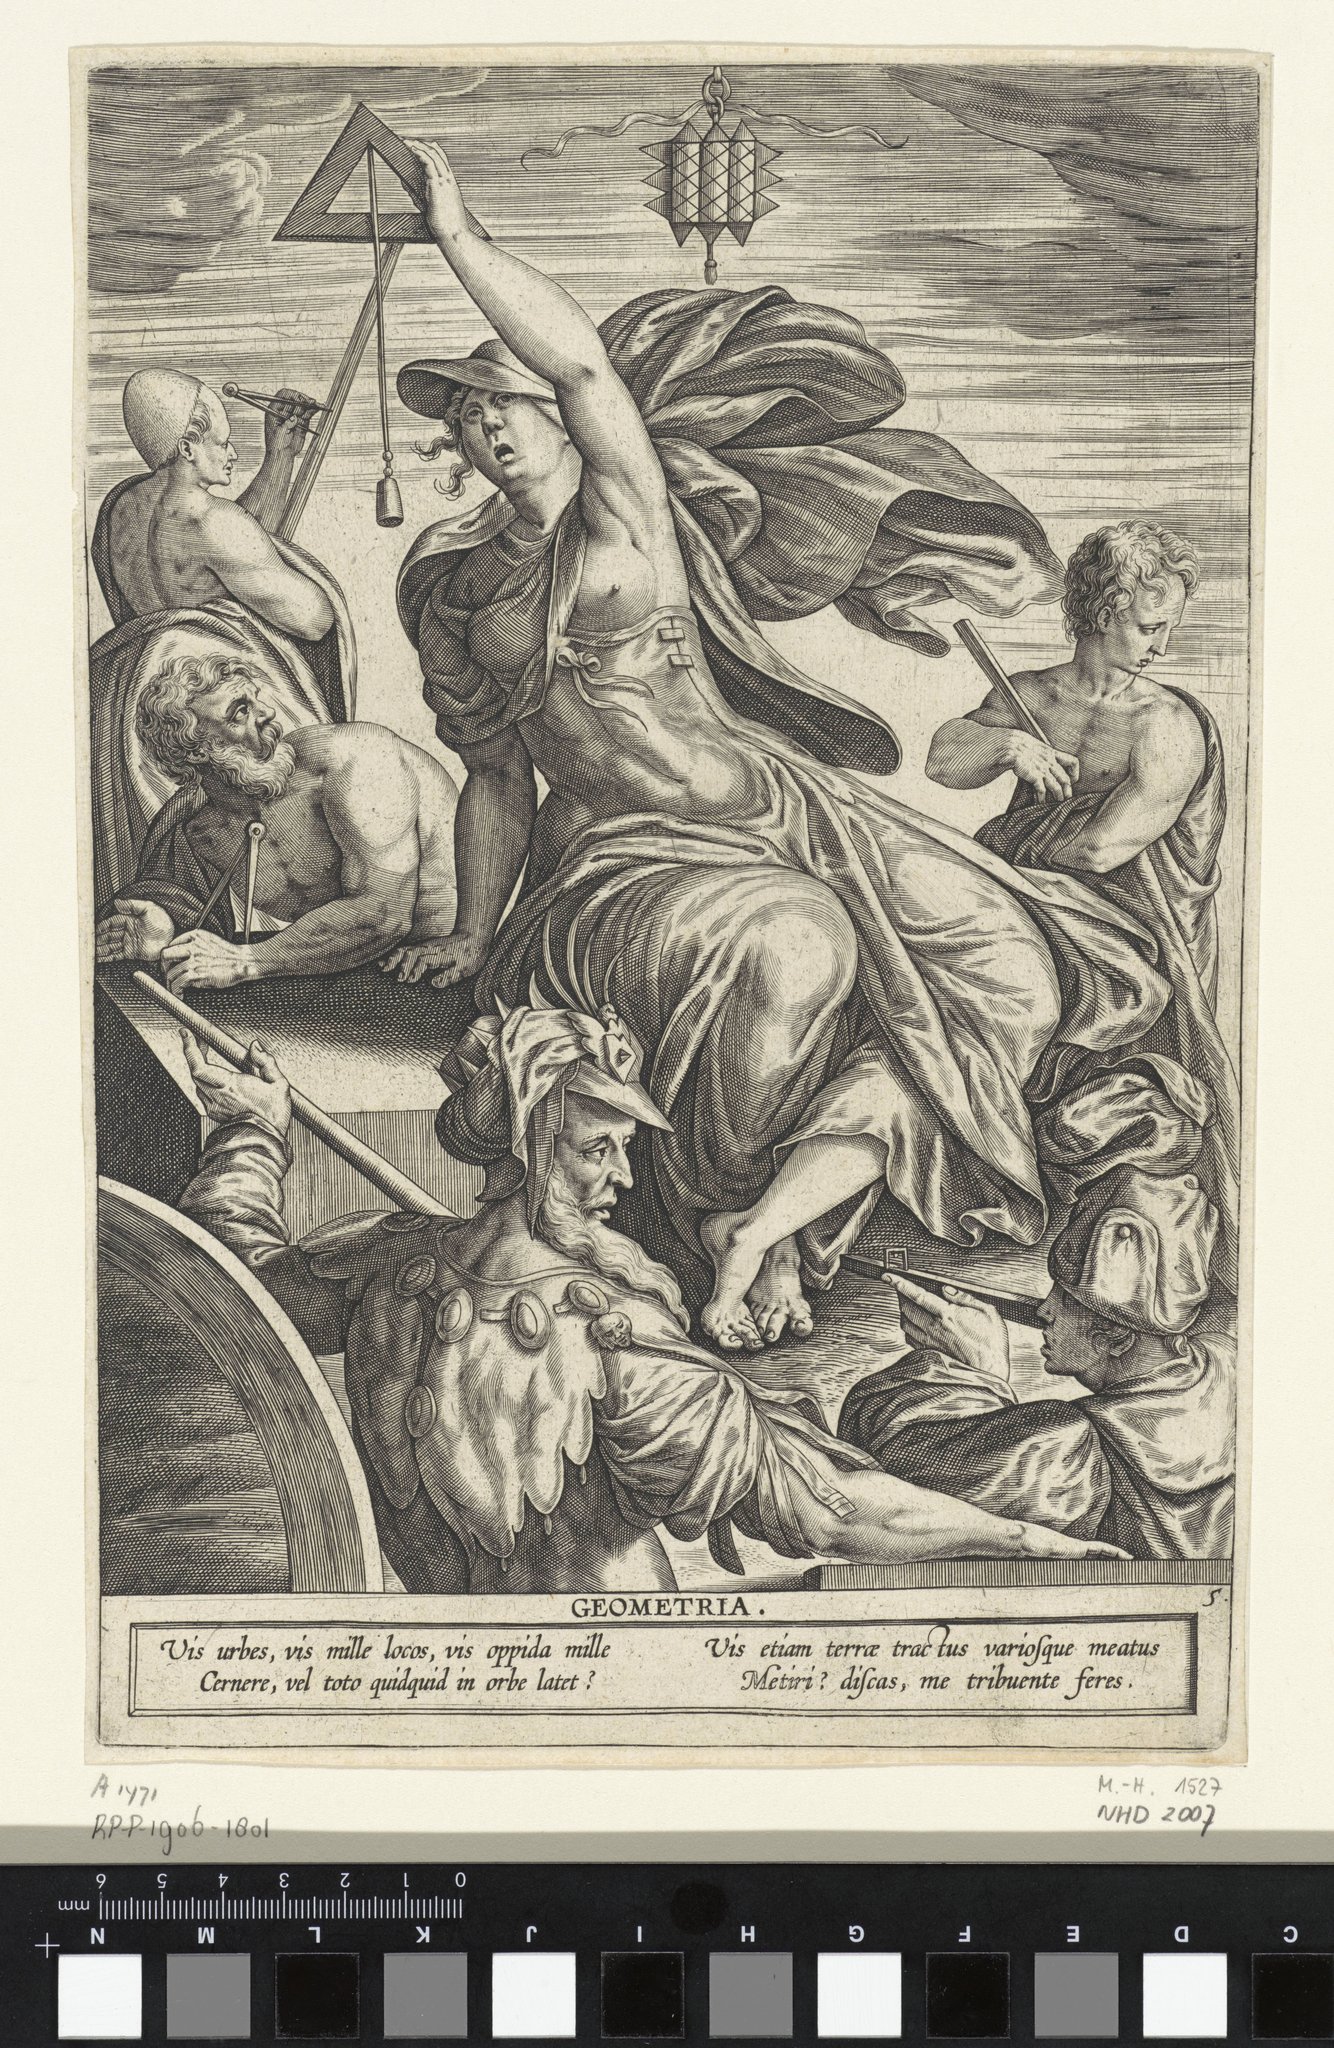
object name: print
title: Geometria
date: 1592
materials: paper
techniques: engraving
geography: antwerp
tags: 'geometria' (~ quadrivium); 'geometria' (ripa)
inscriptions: collector's mark: Lugt 2228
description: De vrouwelijke personificatie van Meetkunde, in haar hand een tekendriehoek met een schietlood. Rondom haar figuren die op diverse wijzen metingen uitvoeren. In het kader in de marge een vierregelig onderschrift, in twee kolommen, in het Latijn.